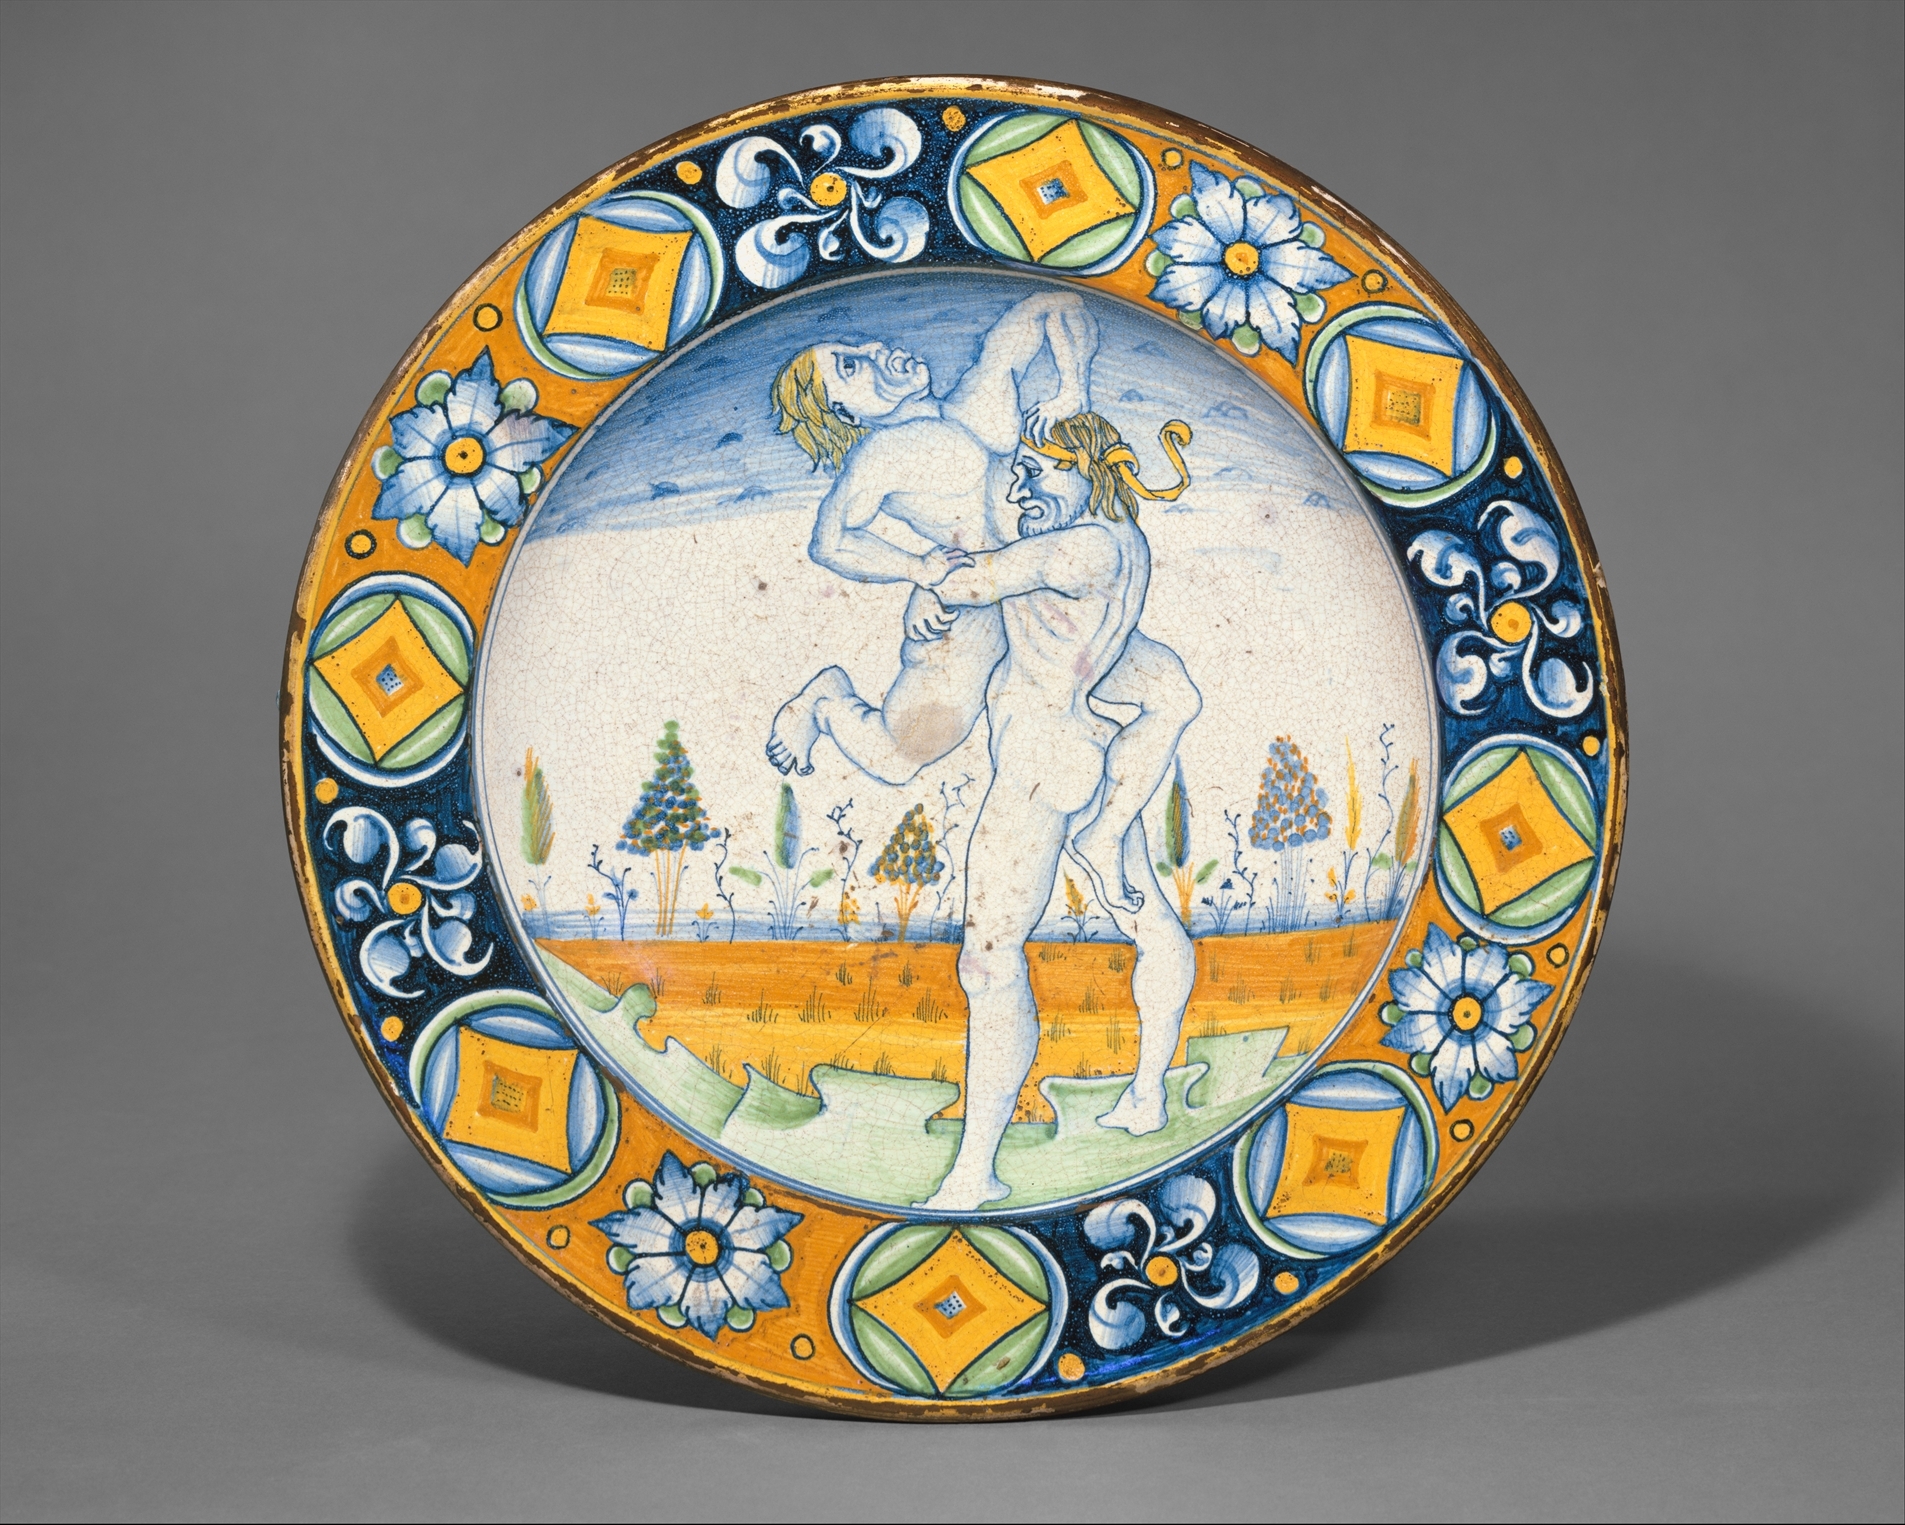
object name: dish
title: Dish (piatto); The story of Hercules: Hercules lifts the giant Antaeus clear of the Earth, his mother, from whom he derived his phenomenal strength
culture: italian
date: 1490-1500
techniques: maiolica, glazing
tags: hercules